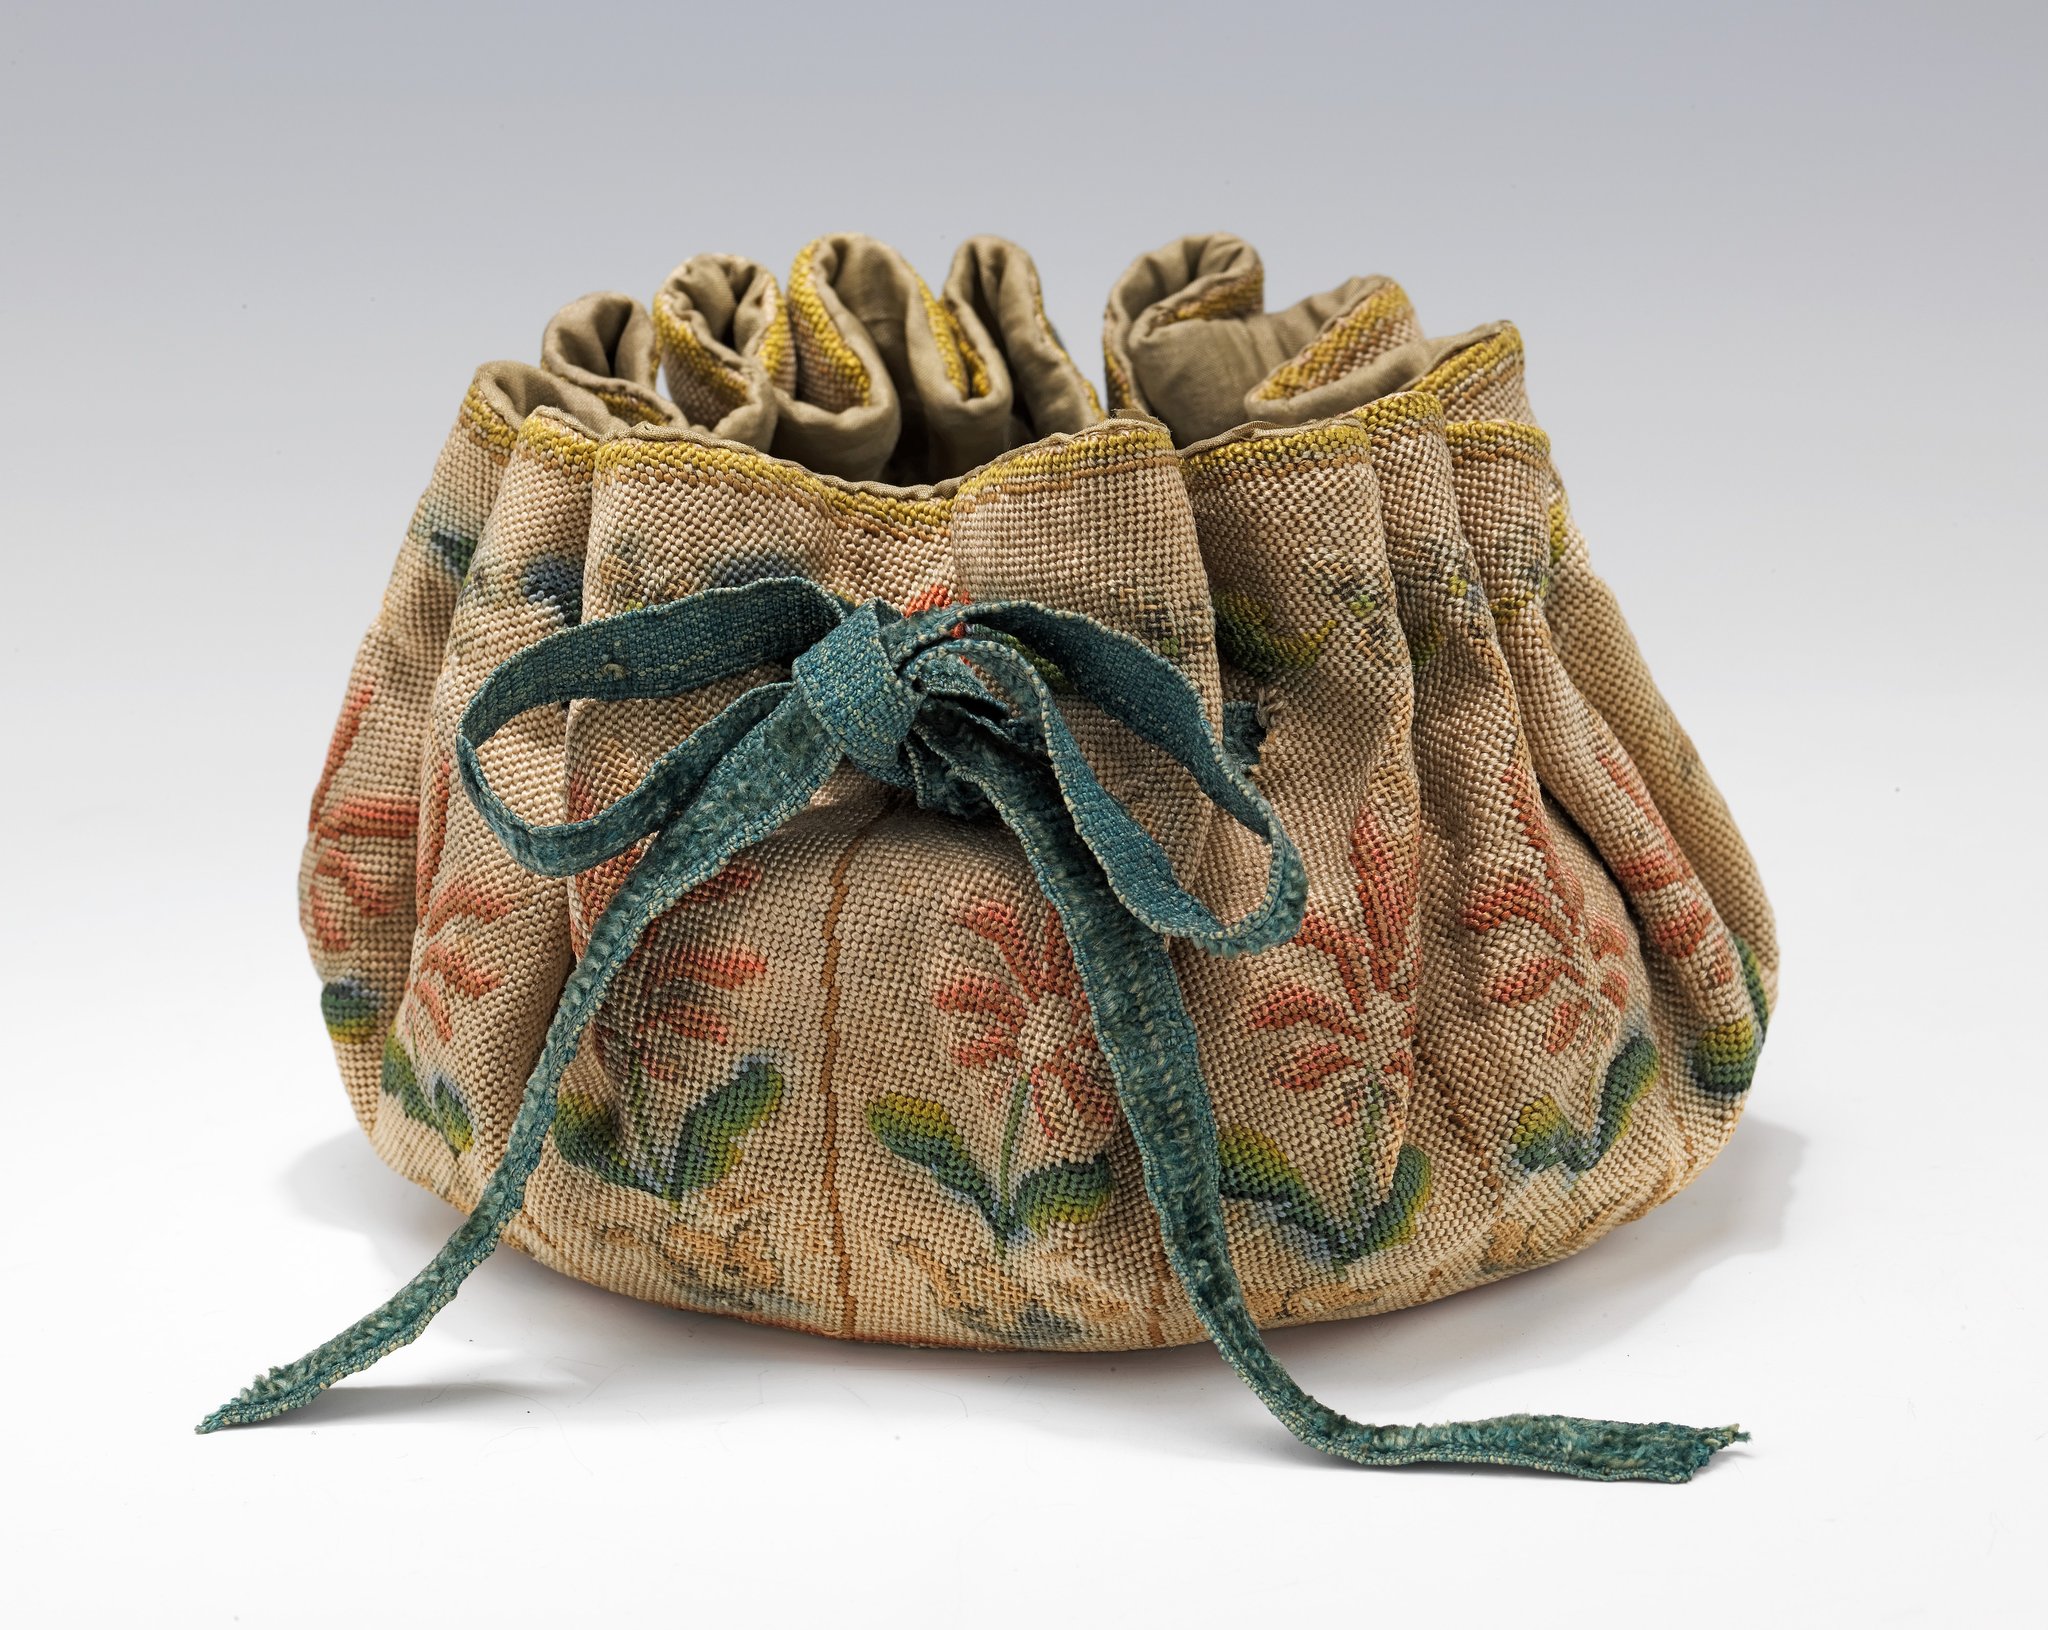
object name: gaming purse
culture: french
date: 1690-1710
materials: linen, silk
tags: flowers